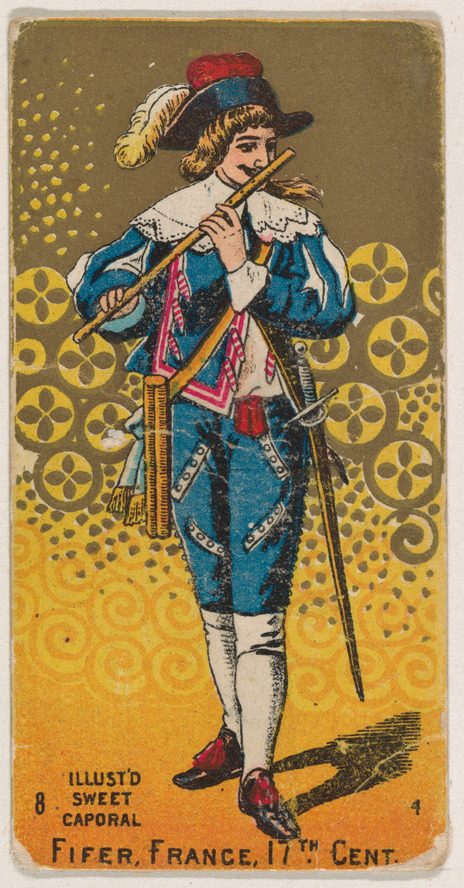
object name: print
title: Fifer, France, 17th Century, from the Military Series (N224) issued by Kinney Tobacco Company to promote Sweet Caporal Cigarettes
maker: kinney brothers tobacco company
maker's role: publisher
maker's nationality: american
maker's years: 1869-2011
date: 1888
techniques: color lithograph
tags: musical instruments,military,swords,men